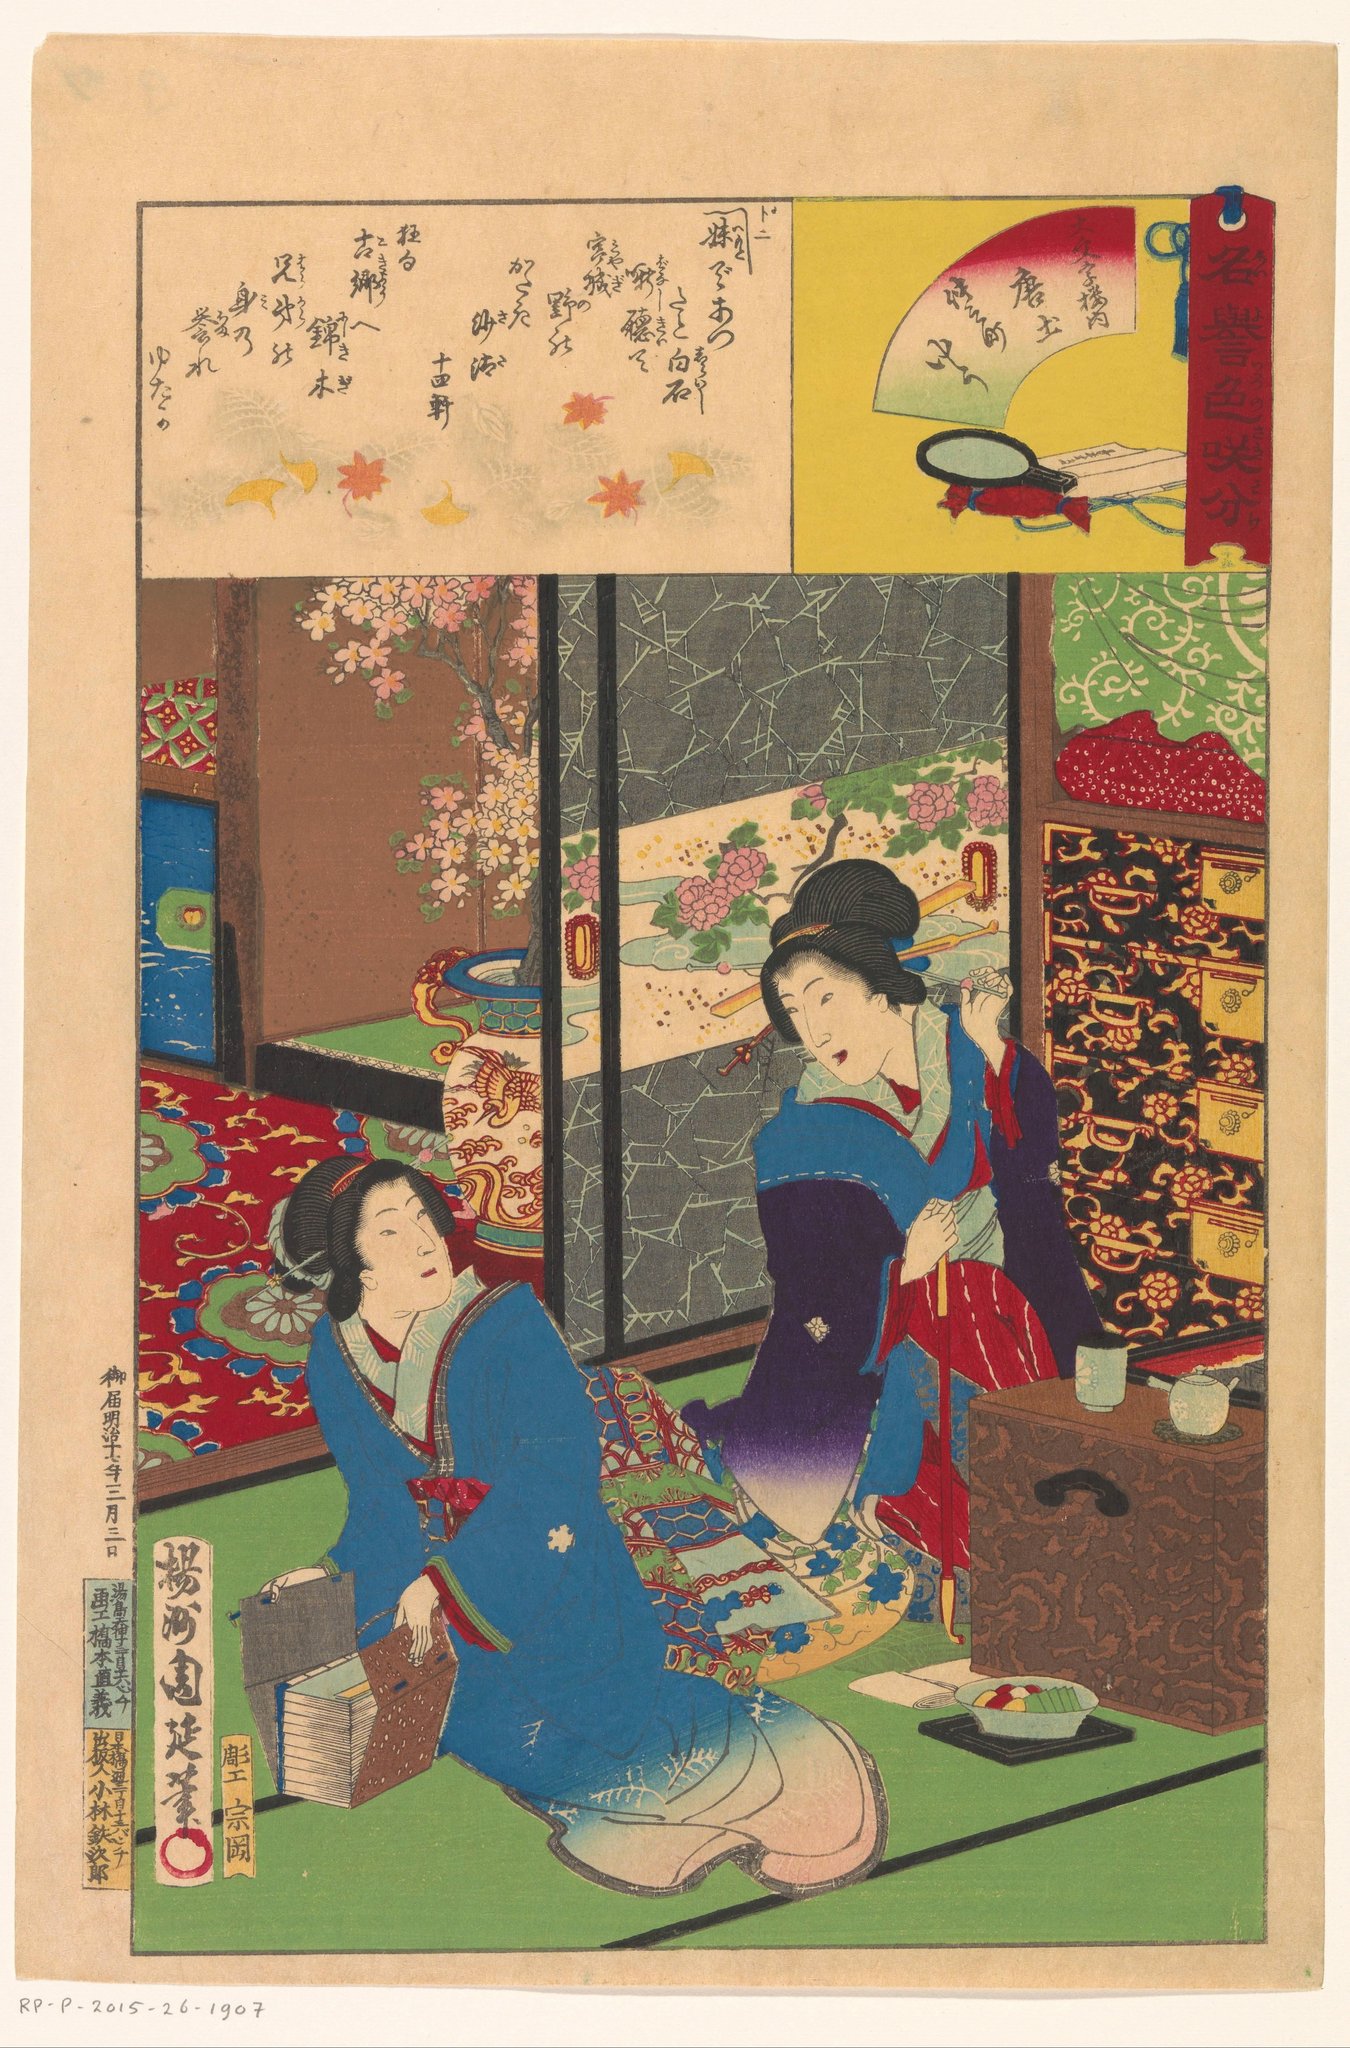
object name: print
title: Twee vrouwen in een interieur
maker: toyohara chikanobu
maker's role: print maker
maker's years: 1838-1912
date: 1848-1912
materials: paper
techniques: blind stamped, woodcut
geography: japan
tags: pipe ~ tobacco, book